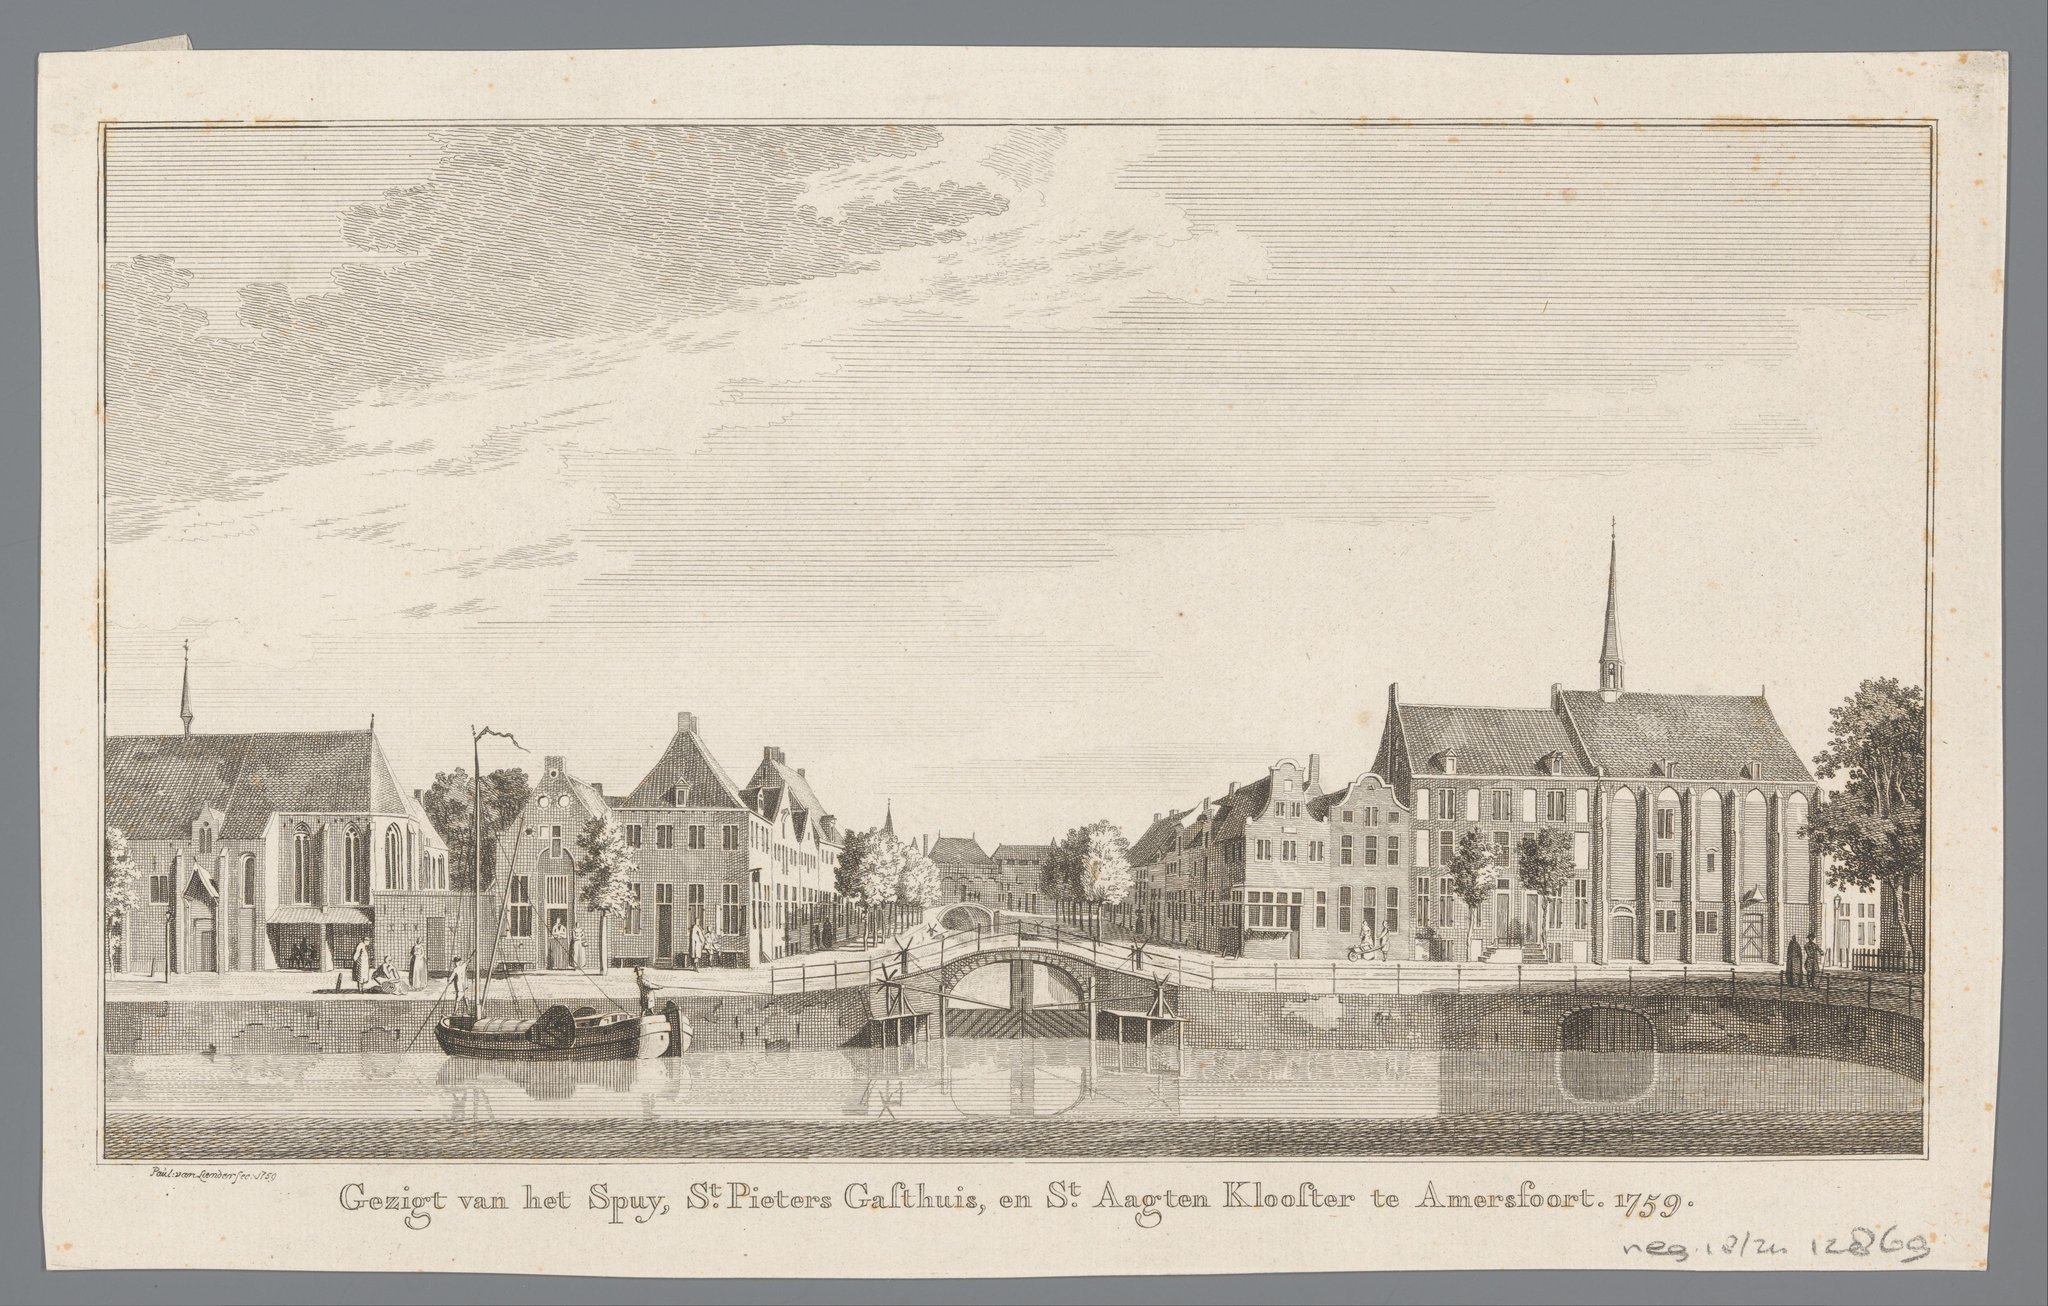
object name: book illustration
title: Gezicht op het Sint-Pietersgasthuis en het Sint-Agathaklooster te Amersfoort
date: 1760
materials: paper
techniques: etching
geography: utrecht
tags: sailing-ship, sailing-boat, church (exterior), bridge in city across river, canal, etc.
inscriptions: collector's mark: Lugt 2228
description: Prent uit: Bemmel, Abraham van. Beschryving der stad Amersfoort (...). 2 dln. Utrecht: Henricus Spruyt, 1760.